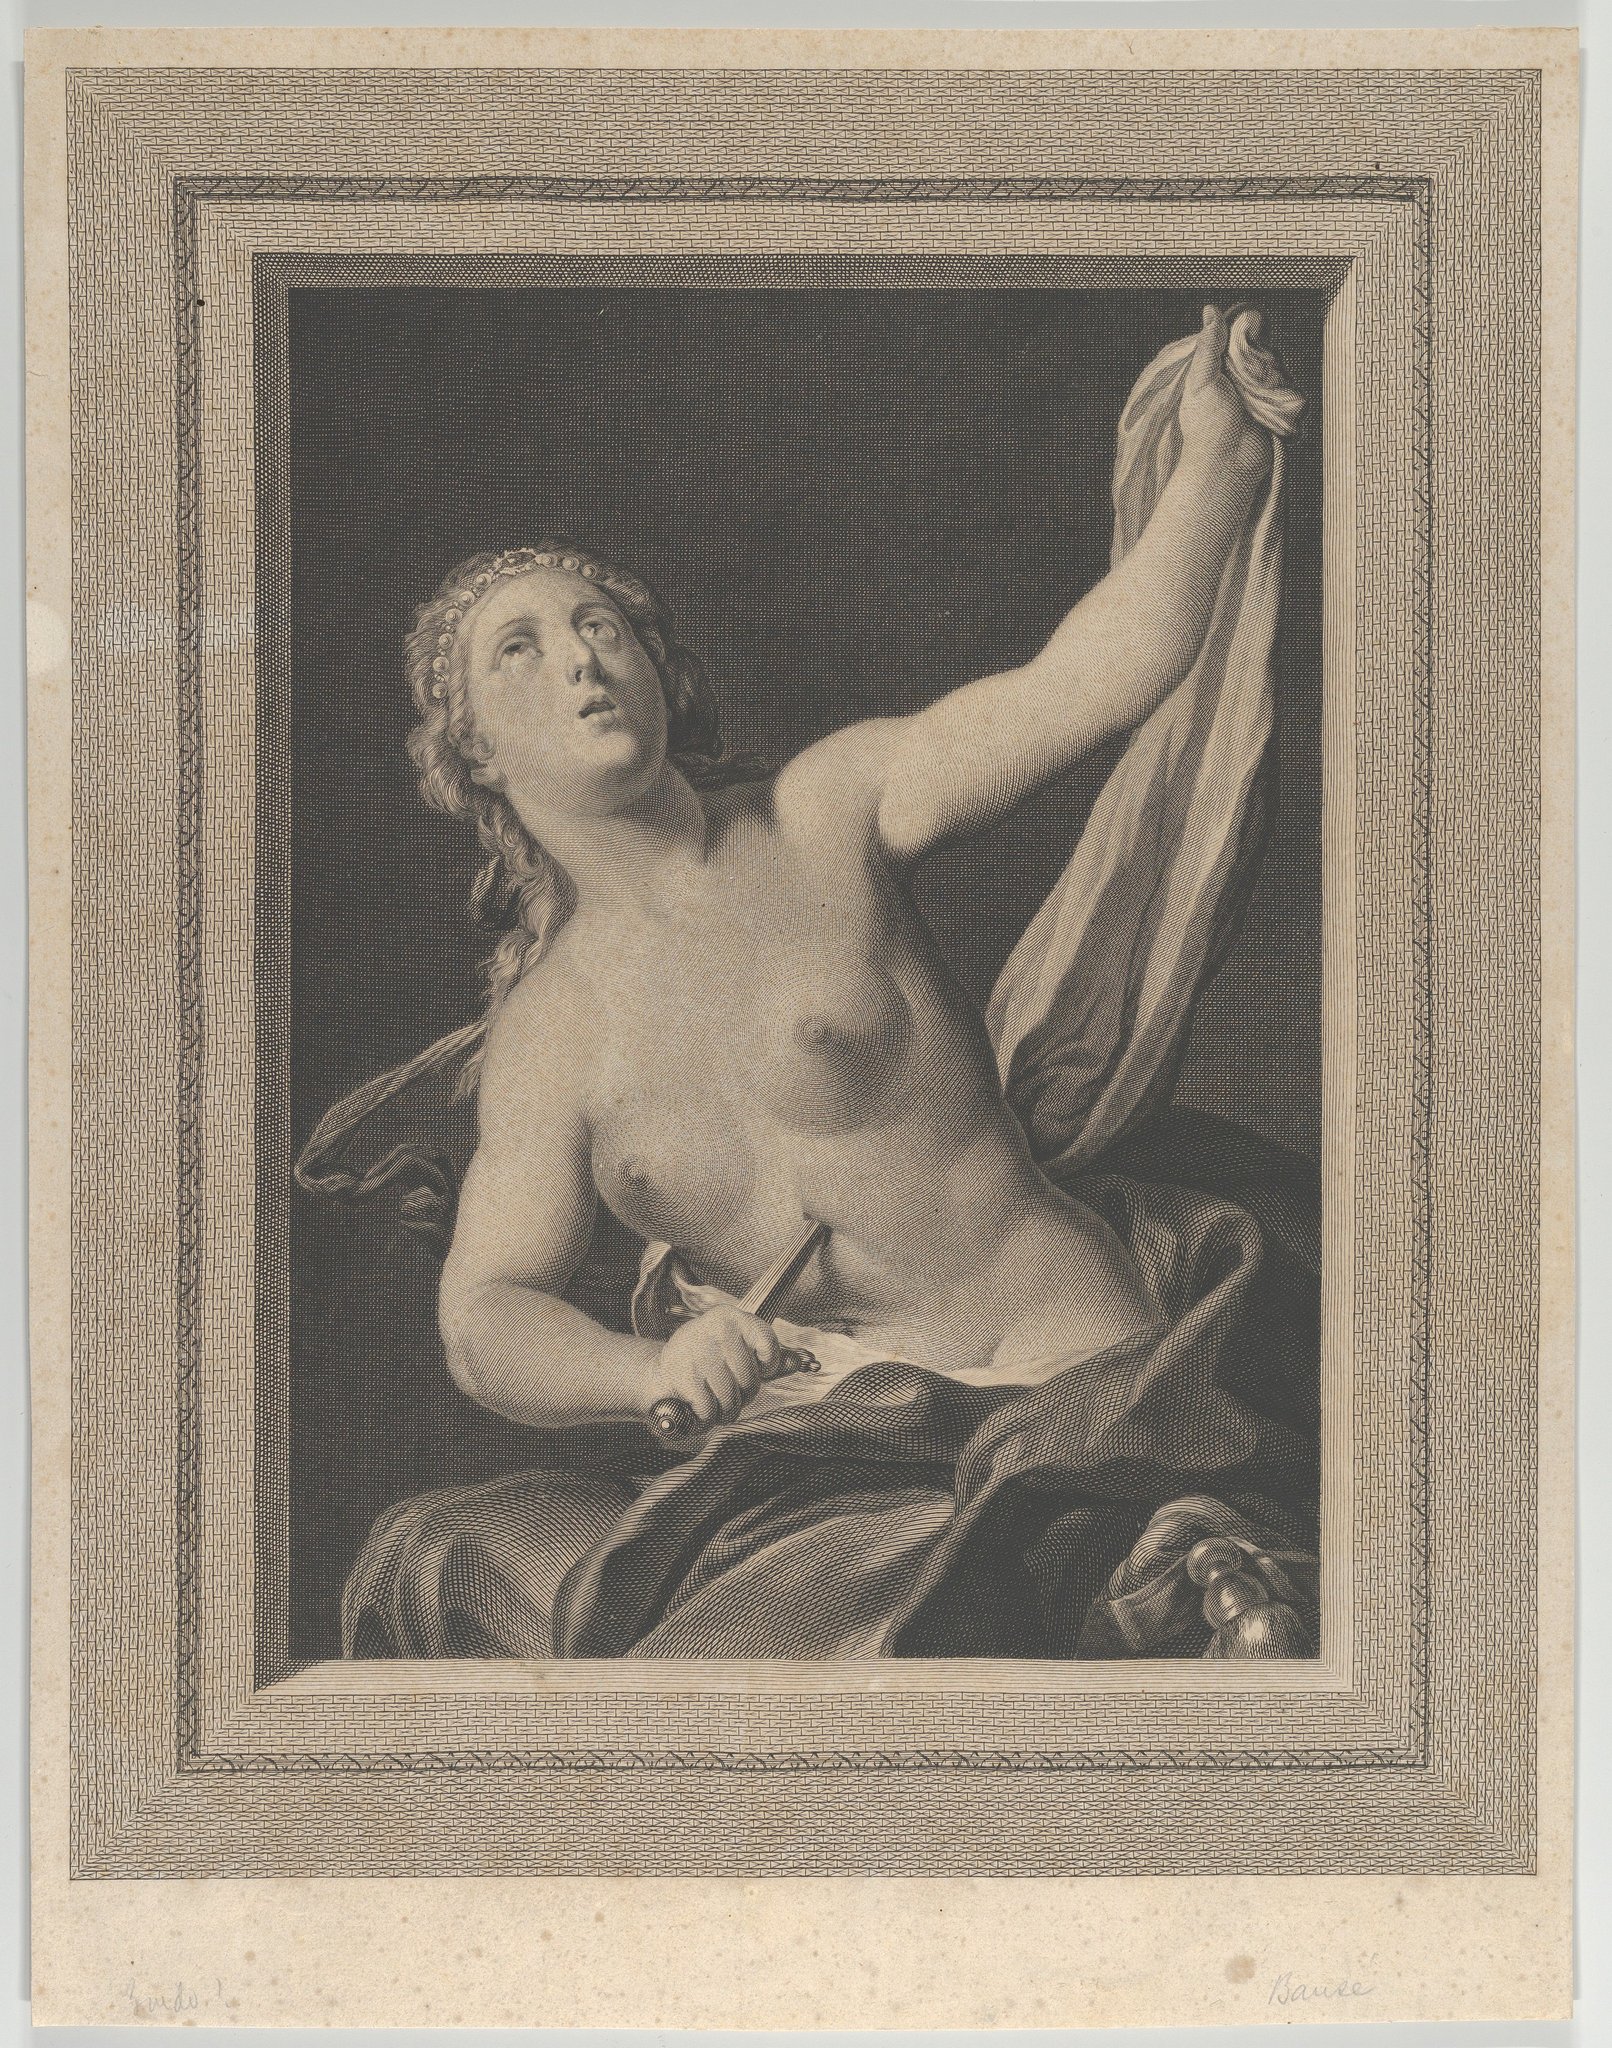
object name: print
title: Lucretia seated, half naked, stabbing herself in the stomach with a dagger in her right hand and holding a cloth in her raised left hand, looking upwards, after Pellegrini?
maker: louis jacques cathelin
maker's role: artist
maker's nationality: french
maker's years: 1739-1804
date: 1782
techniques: engraving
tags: female nudes